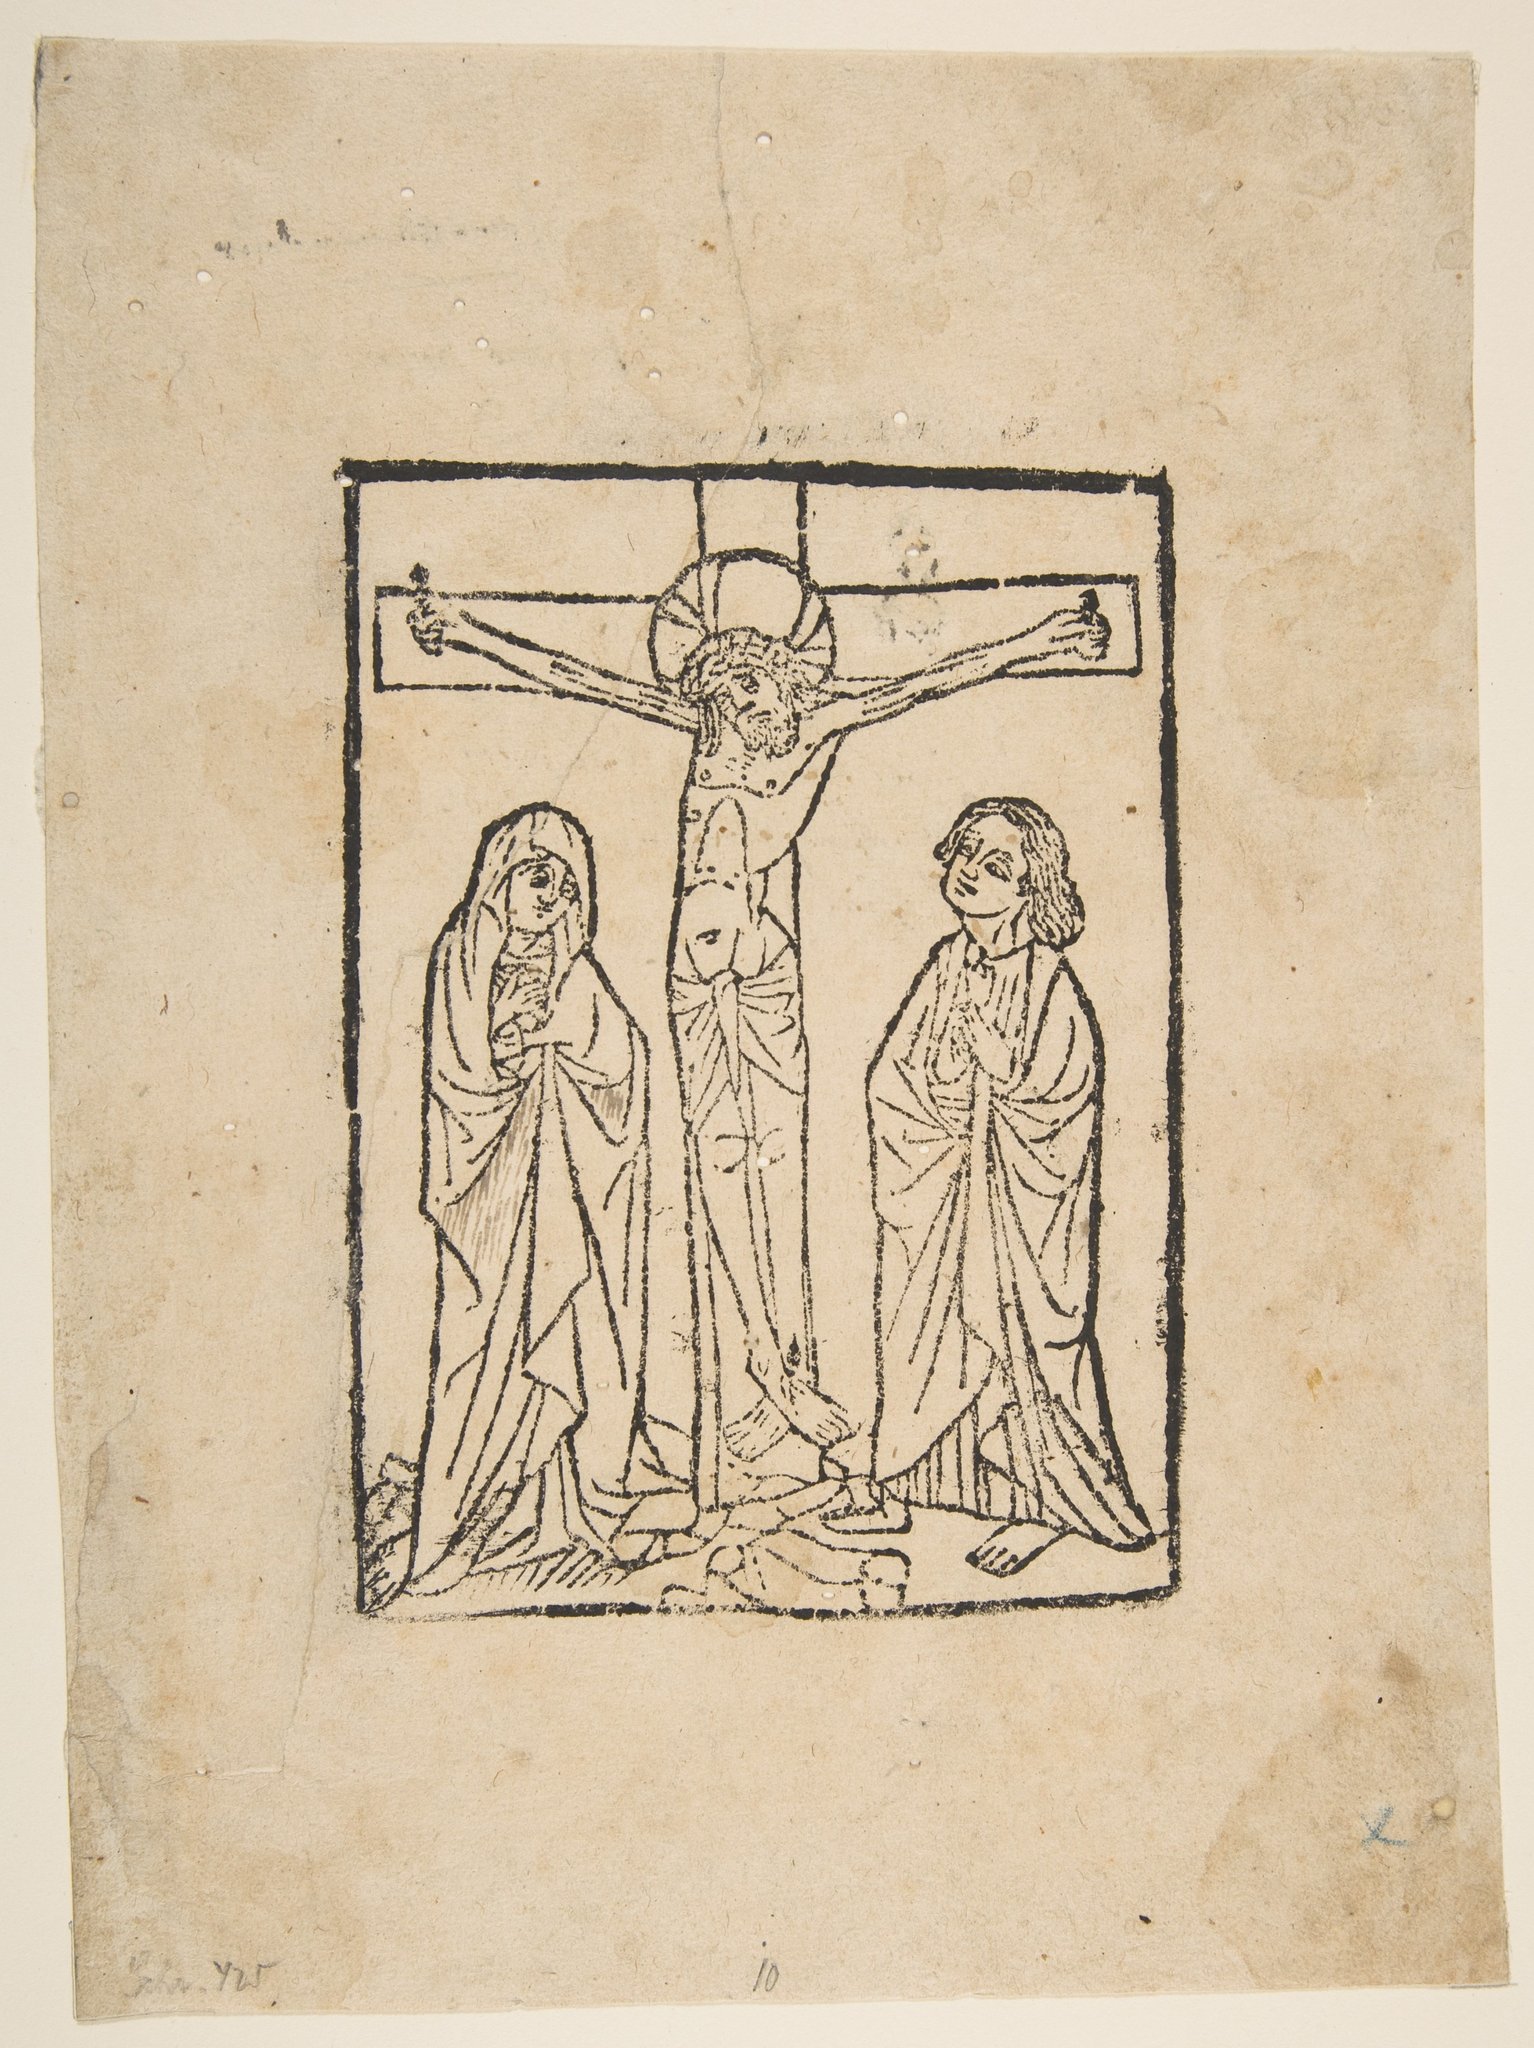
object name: print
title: Christ on the Cross, with the Virgin and Saint John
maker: anonymous, 15th century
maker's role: artist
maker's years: 1400-1500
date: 1401-1500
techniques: woodcut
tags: christ,virgin mary,cross,saints